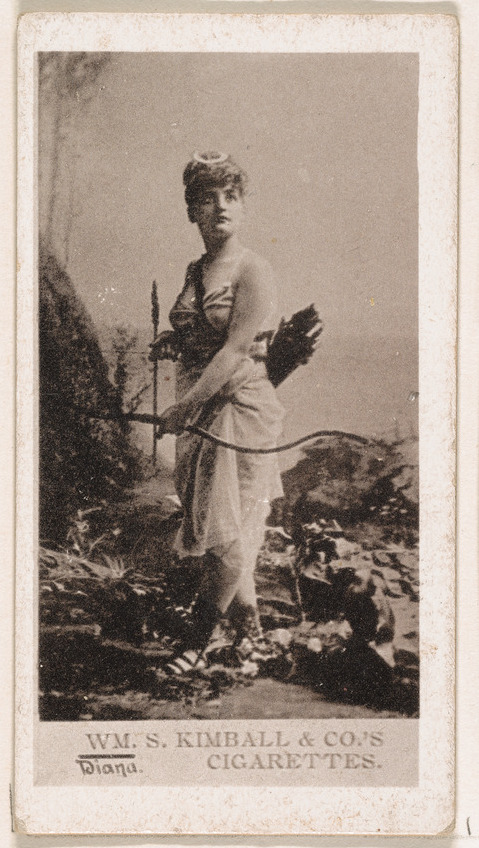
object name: photograph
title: Diana, from the Actresses series (N203) issued by Wm. S. Kimball & Co.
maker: william s. kimball & company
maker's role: publisher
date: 1889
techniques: color lithograph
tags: bow and arrow,portraits,women,actresses